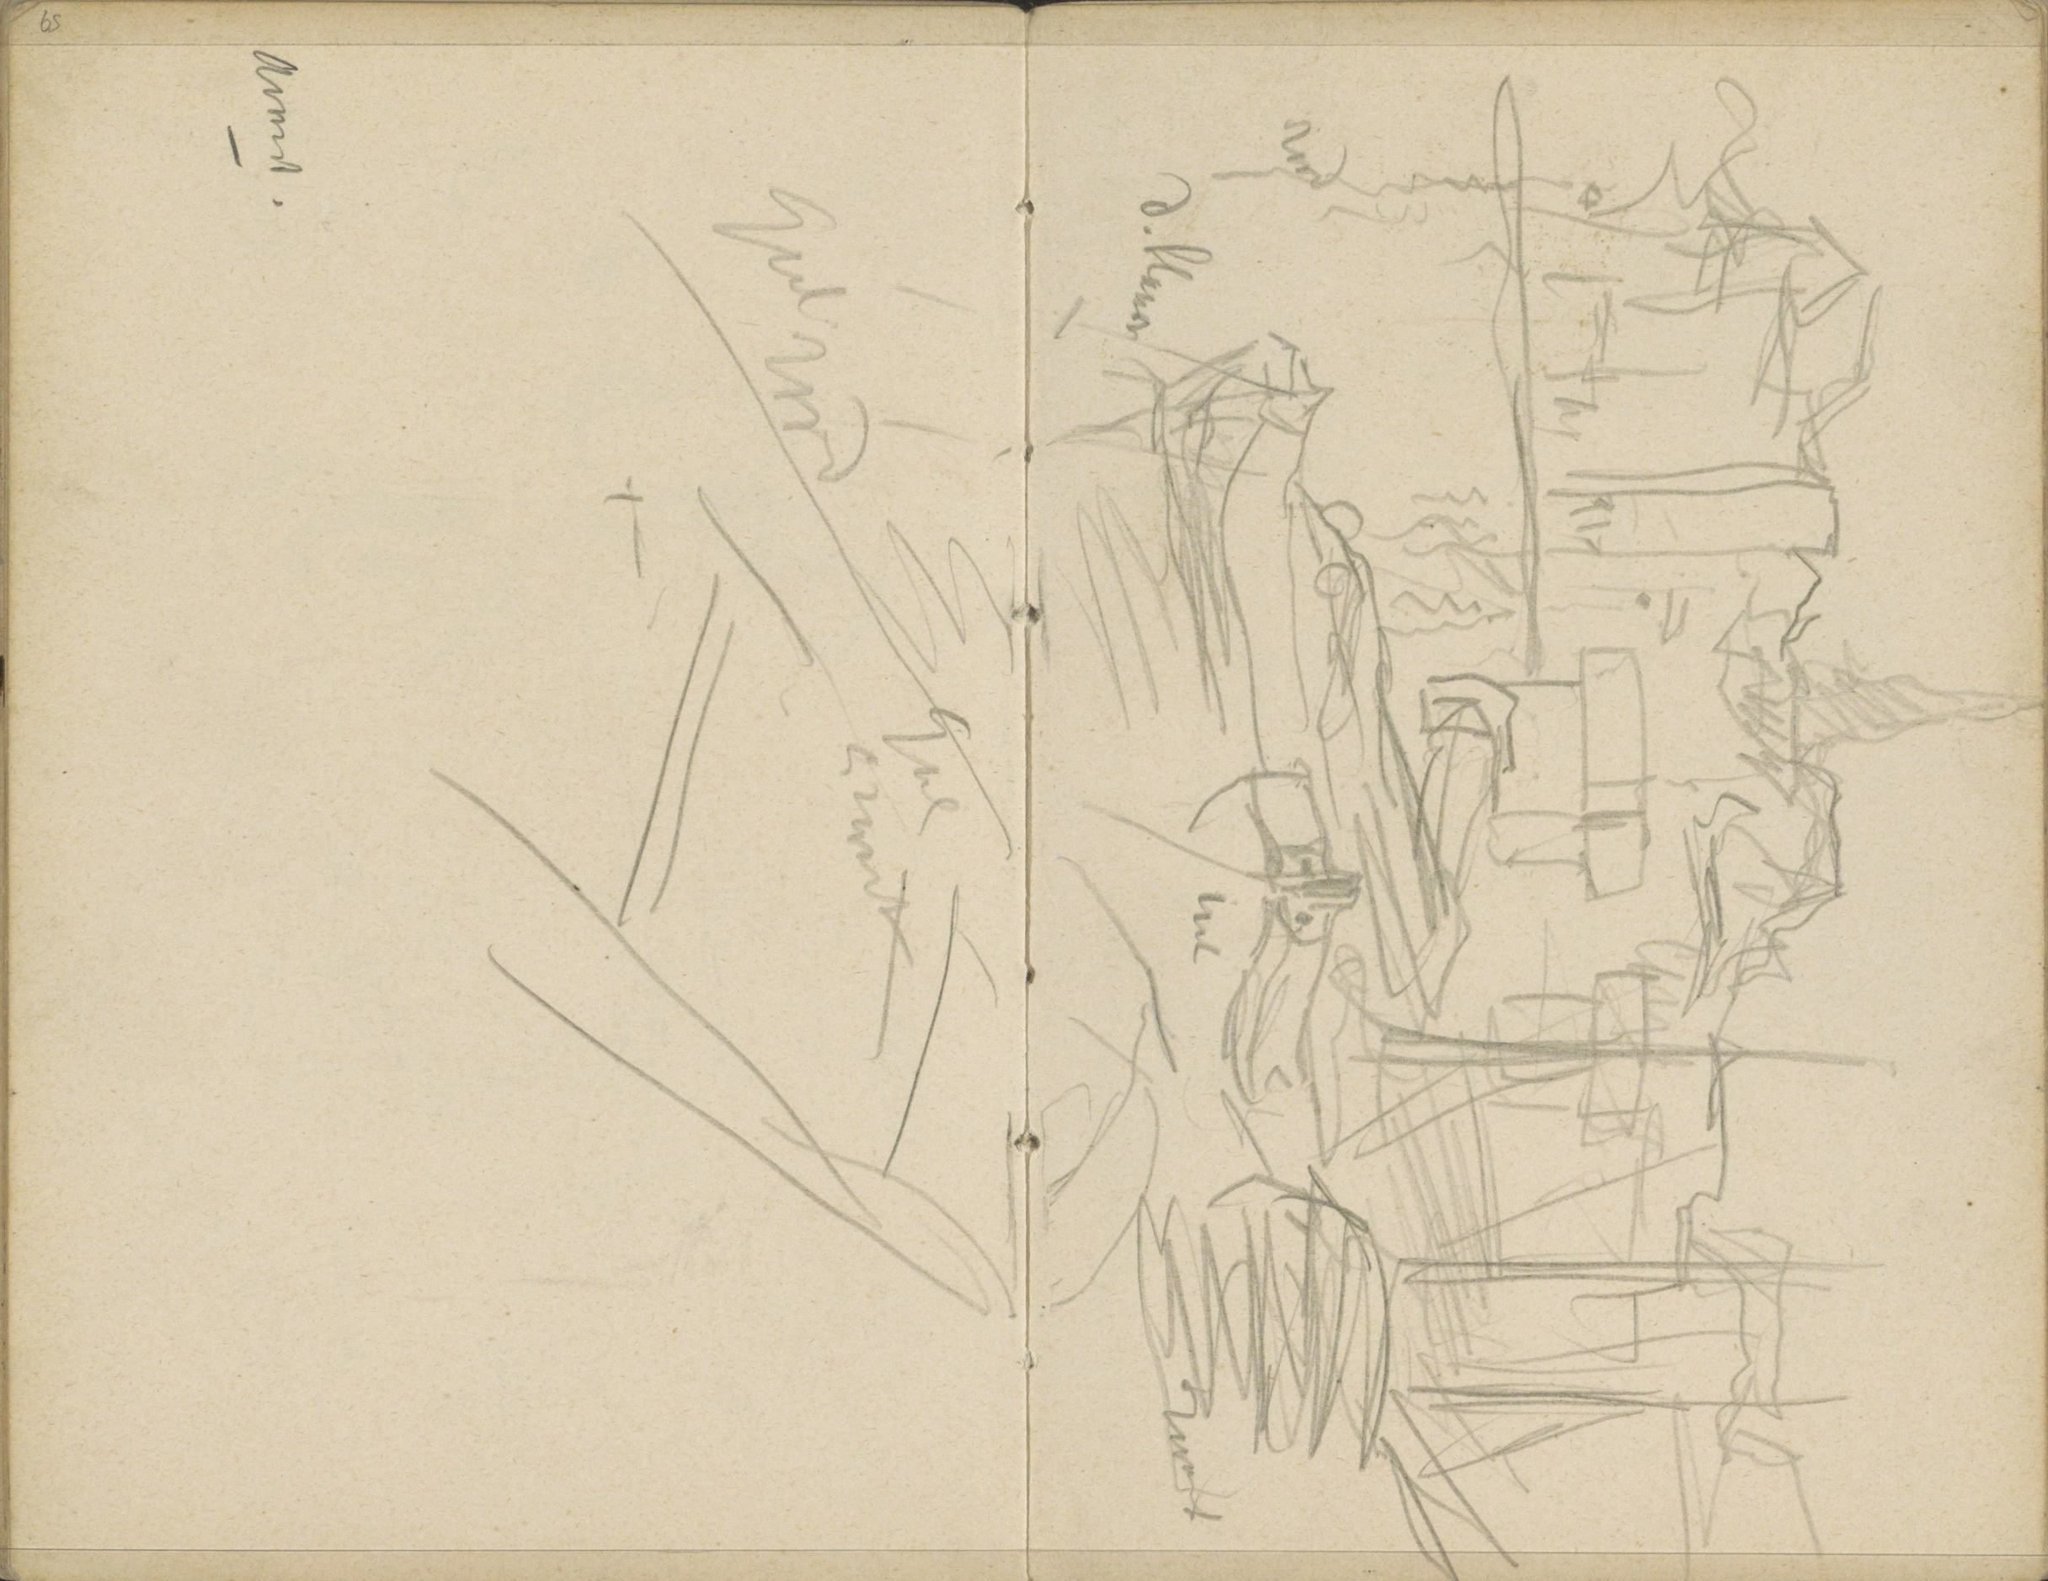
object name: sketchbook leaf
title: Gezicht op boten aan het Damrak te Amsterdam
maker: george hendrik breitner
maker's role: draughtsman, painter, print maker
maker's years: 1857-1923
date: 1903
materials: paper, pencil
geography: amsterdam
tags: ships (in general), canals, waters (in city), parts of church exterior and annexes: tower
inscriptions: annotation: ‘avond’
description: Gezicht op boten aan het Damrak te Amsterdam. In de verte de toren van de Oude Kerk. Pagina 65 en pagina 66 uit een schetsboek met 46 bladen vervaardigd te Amsterdam en Haarlem.